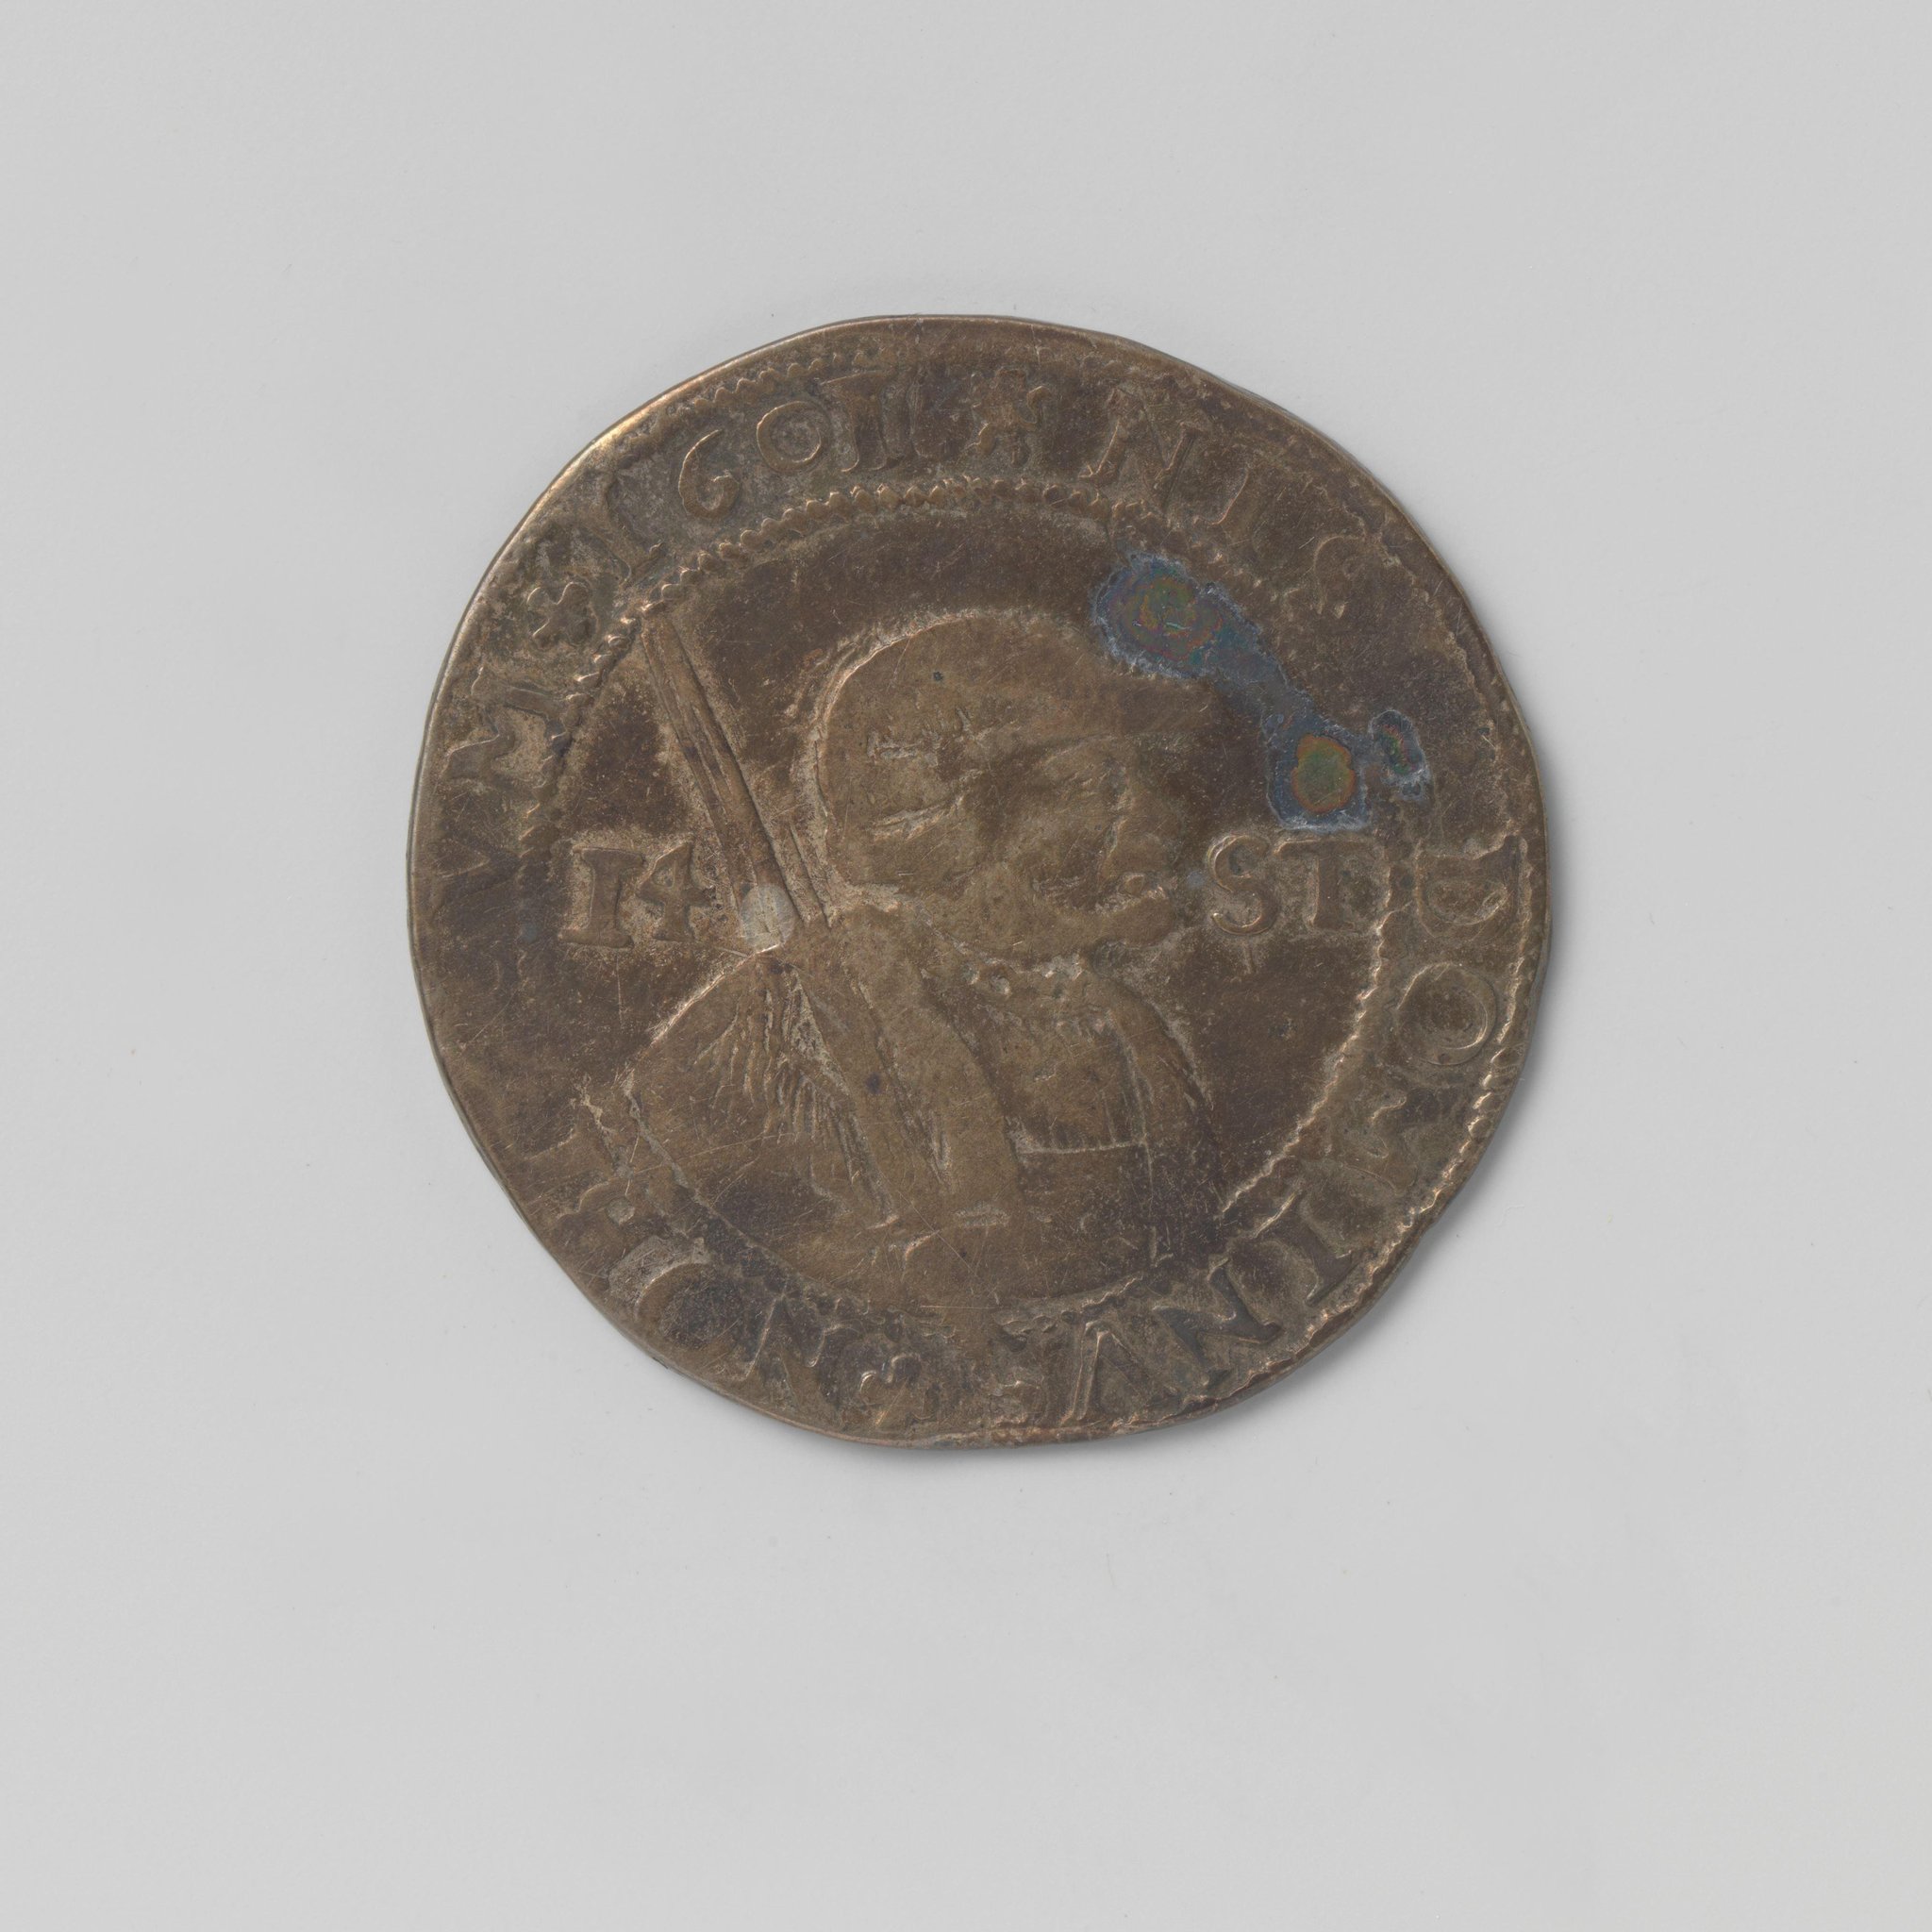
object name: coin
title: Friesland, halve florijn, 1601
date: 1601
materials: silver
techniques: striking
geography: leeuwarden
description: Zilveren munt. Voorzijde: tussen waarde-aanduiding edelman met muts naar rechts. In rechterhand zwaard. In omschrift jaartal Keerzijde: op kort gebloemd kruis gekroond wapenschild van Friesland.